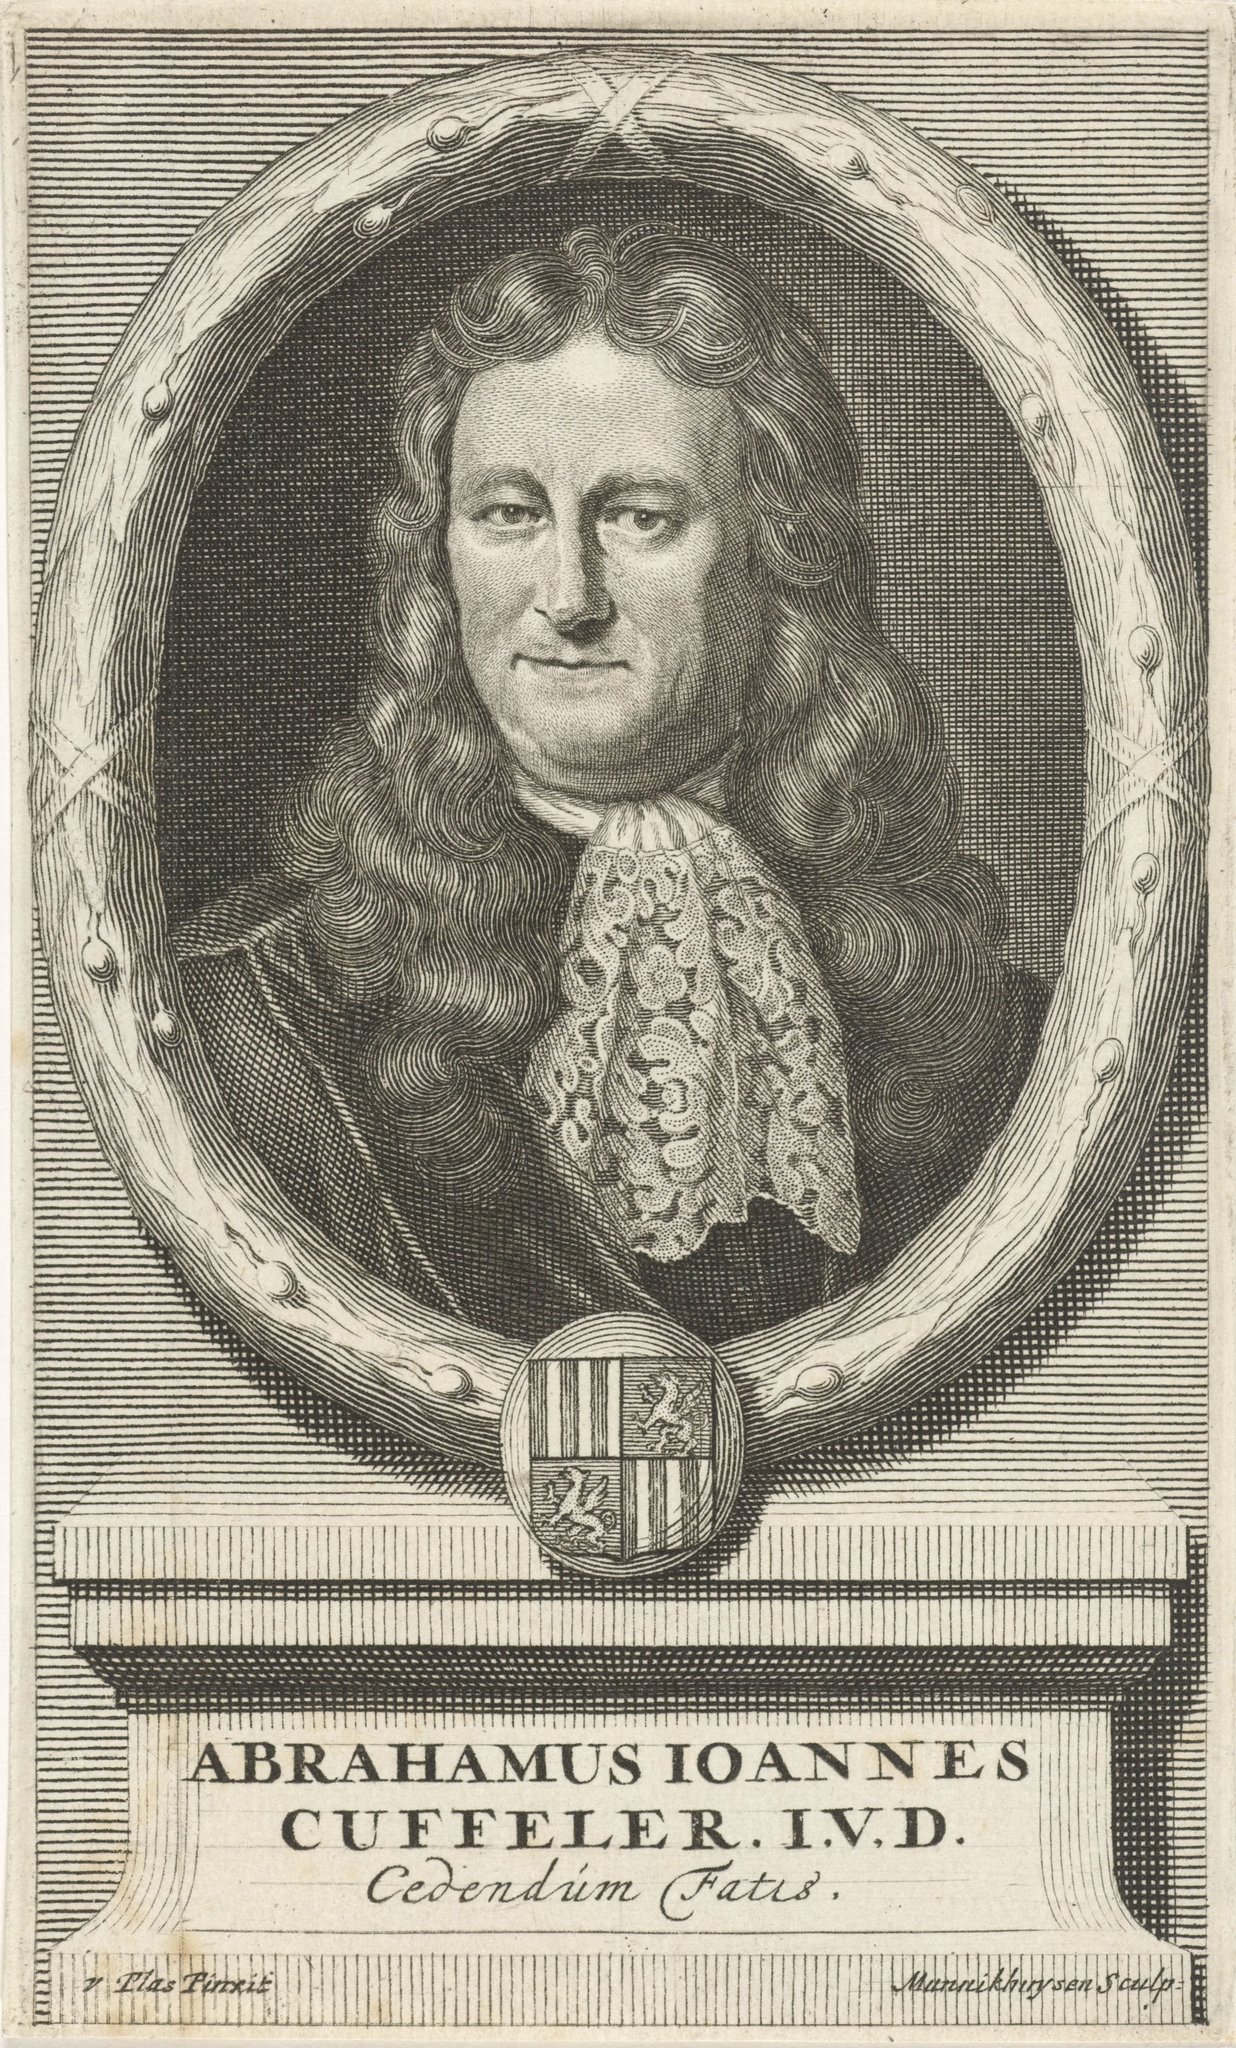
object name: print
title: Portret van Abraham Johannes Kuffeler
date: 1685-1721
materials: paper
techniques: engraving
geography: netherlands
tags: the hague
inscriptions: collector's mark: Lugt 2228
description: Portret van Abraham Johannes Kuffeler, wetenschapper en volgeling van Spinoza. Midden onder op de lijst zijn wapenschild.